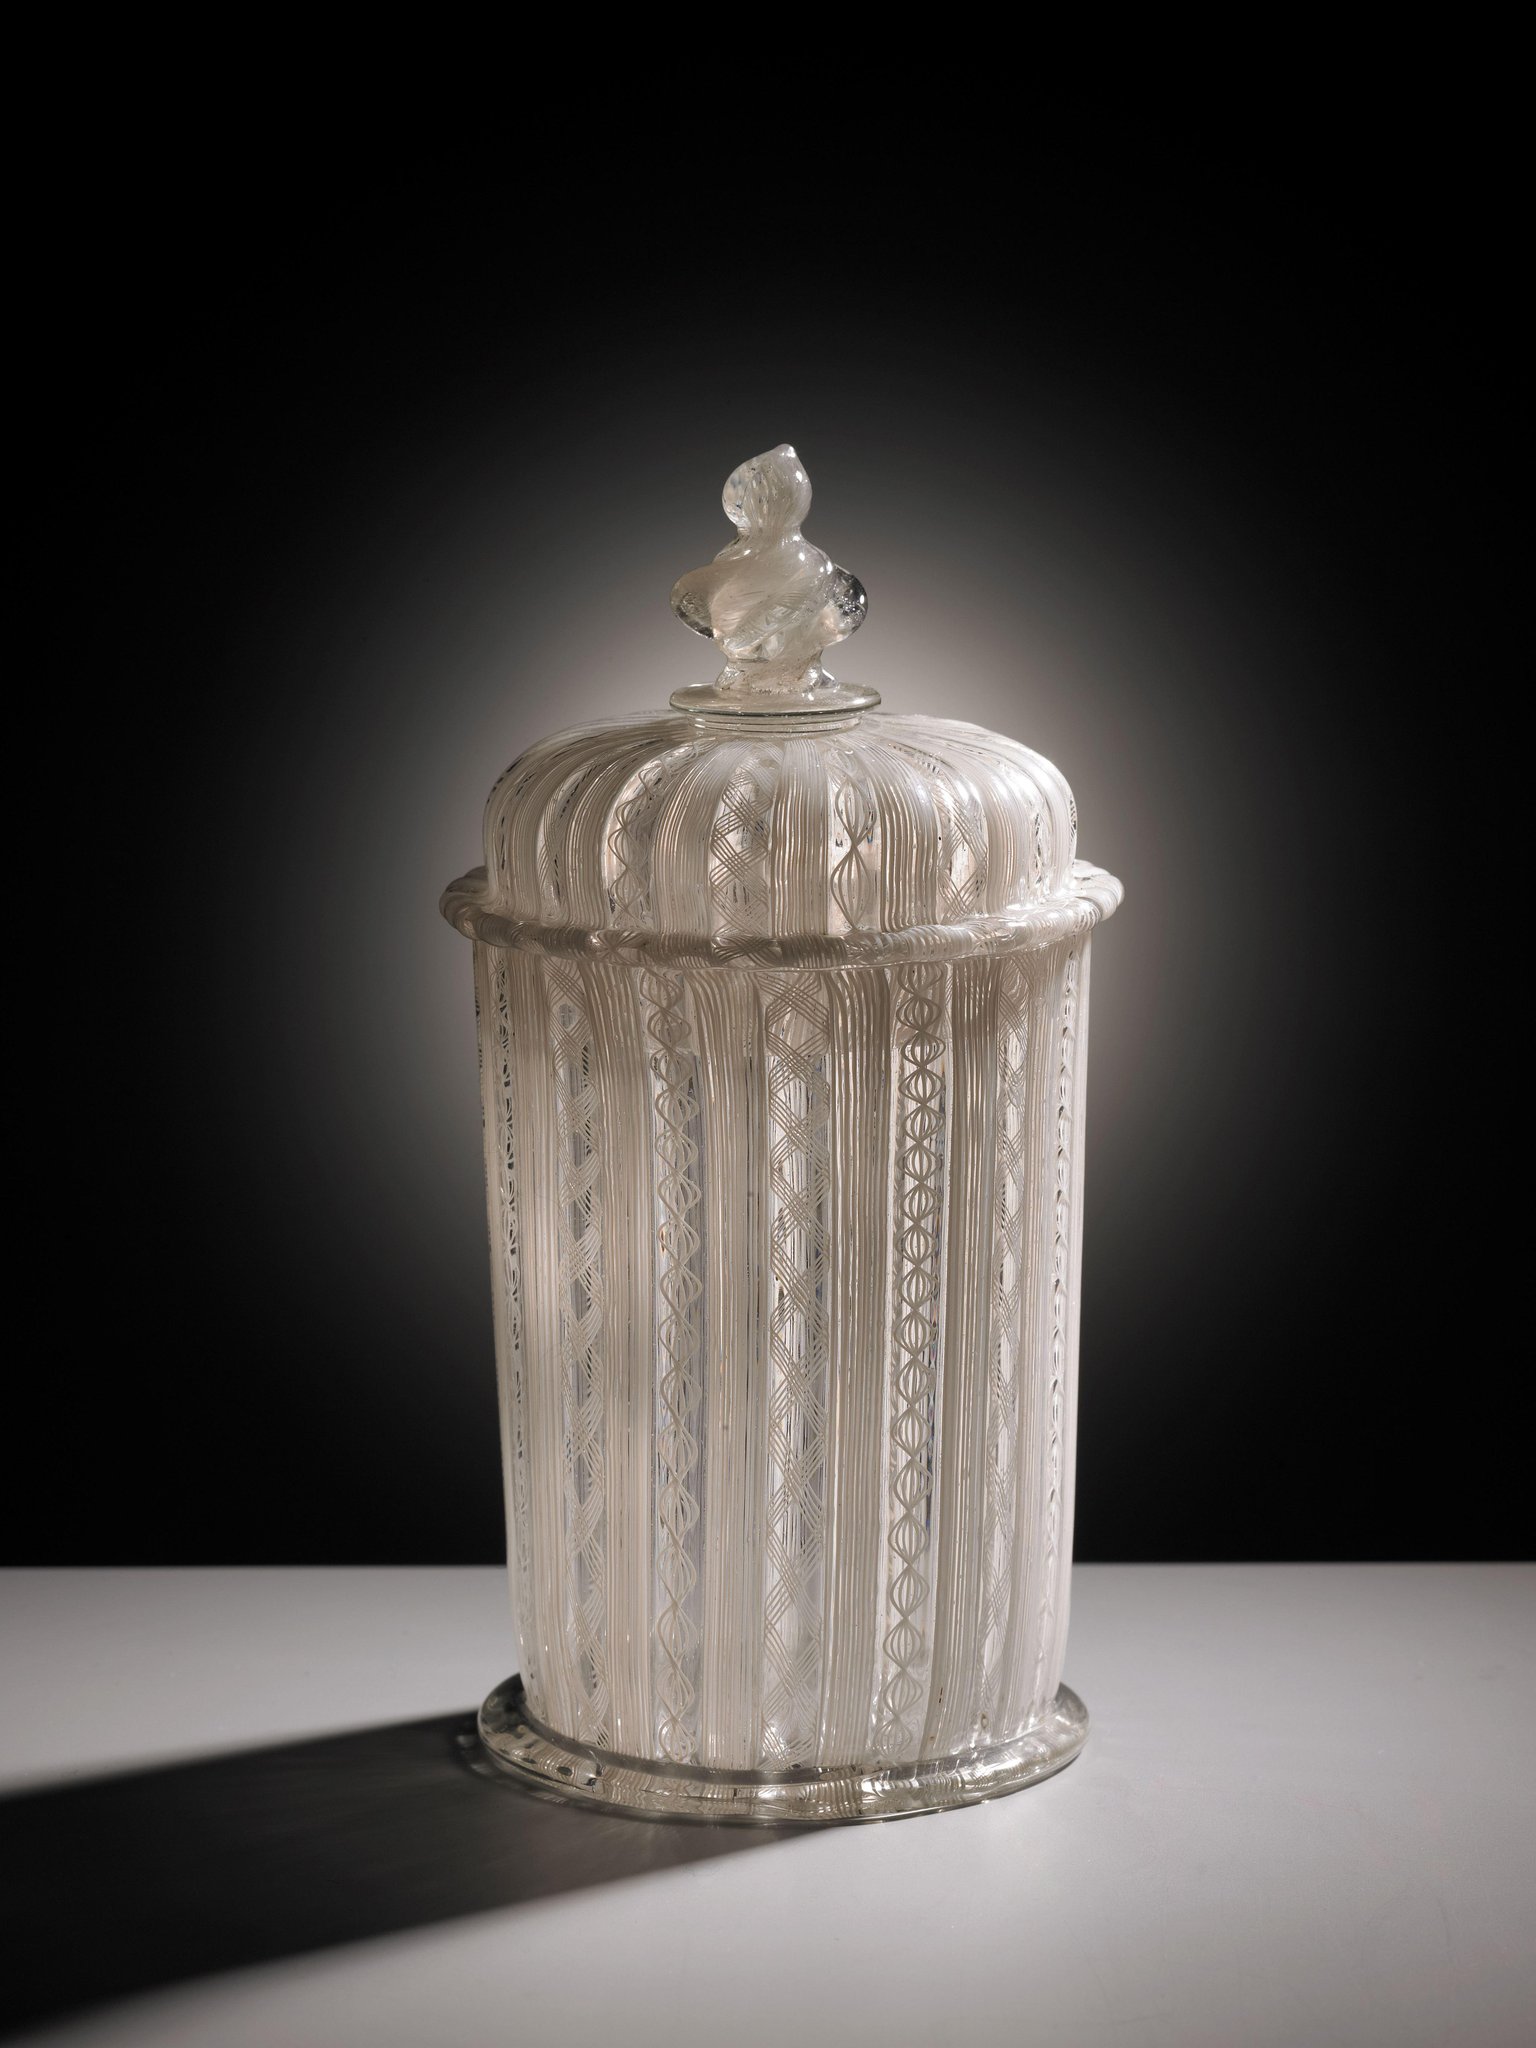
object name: lid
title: Deksel van filigraanglas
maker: Anonymous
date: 1650-1700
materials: glass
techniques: façon de venise, glassblowing, vetro a retorti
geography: low countries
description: Gewelfd deksel met overkragende rand en getordeerde knop met één schijf. Deksel en knop van filigraanglas a fili en a retortoli.